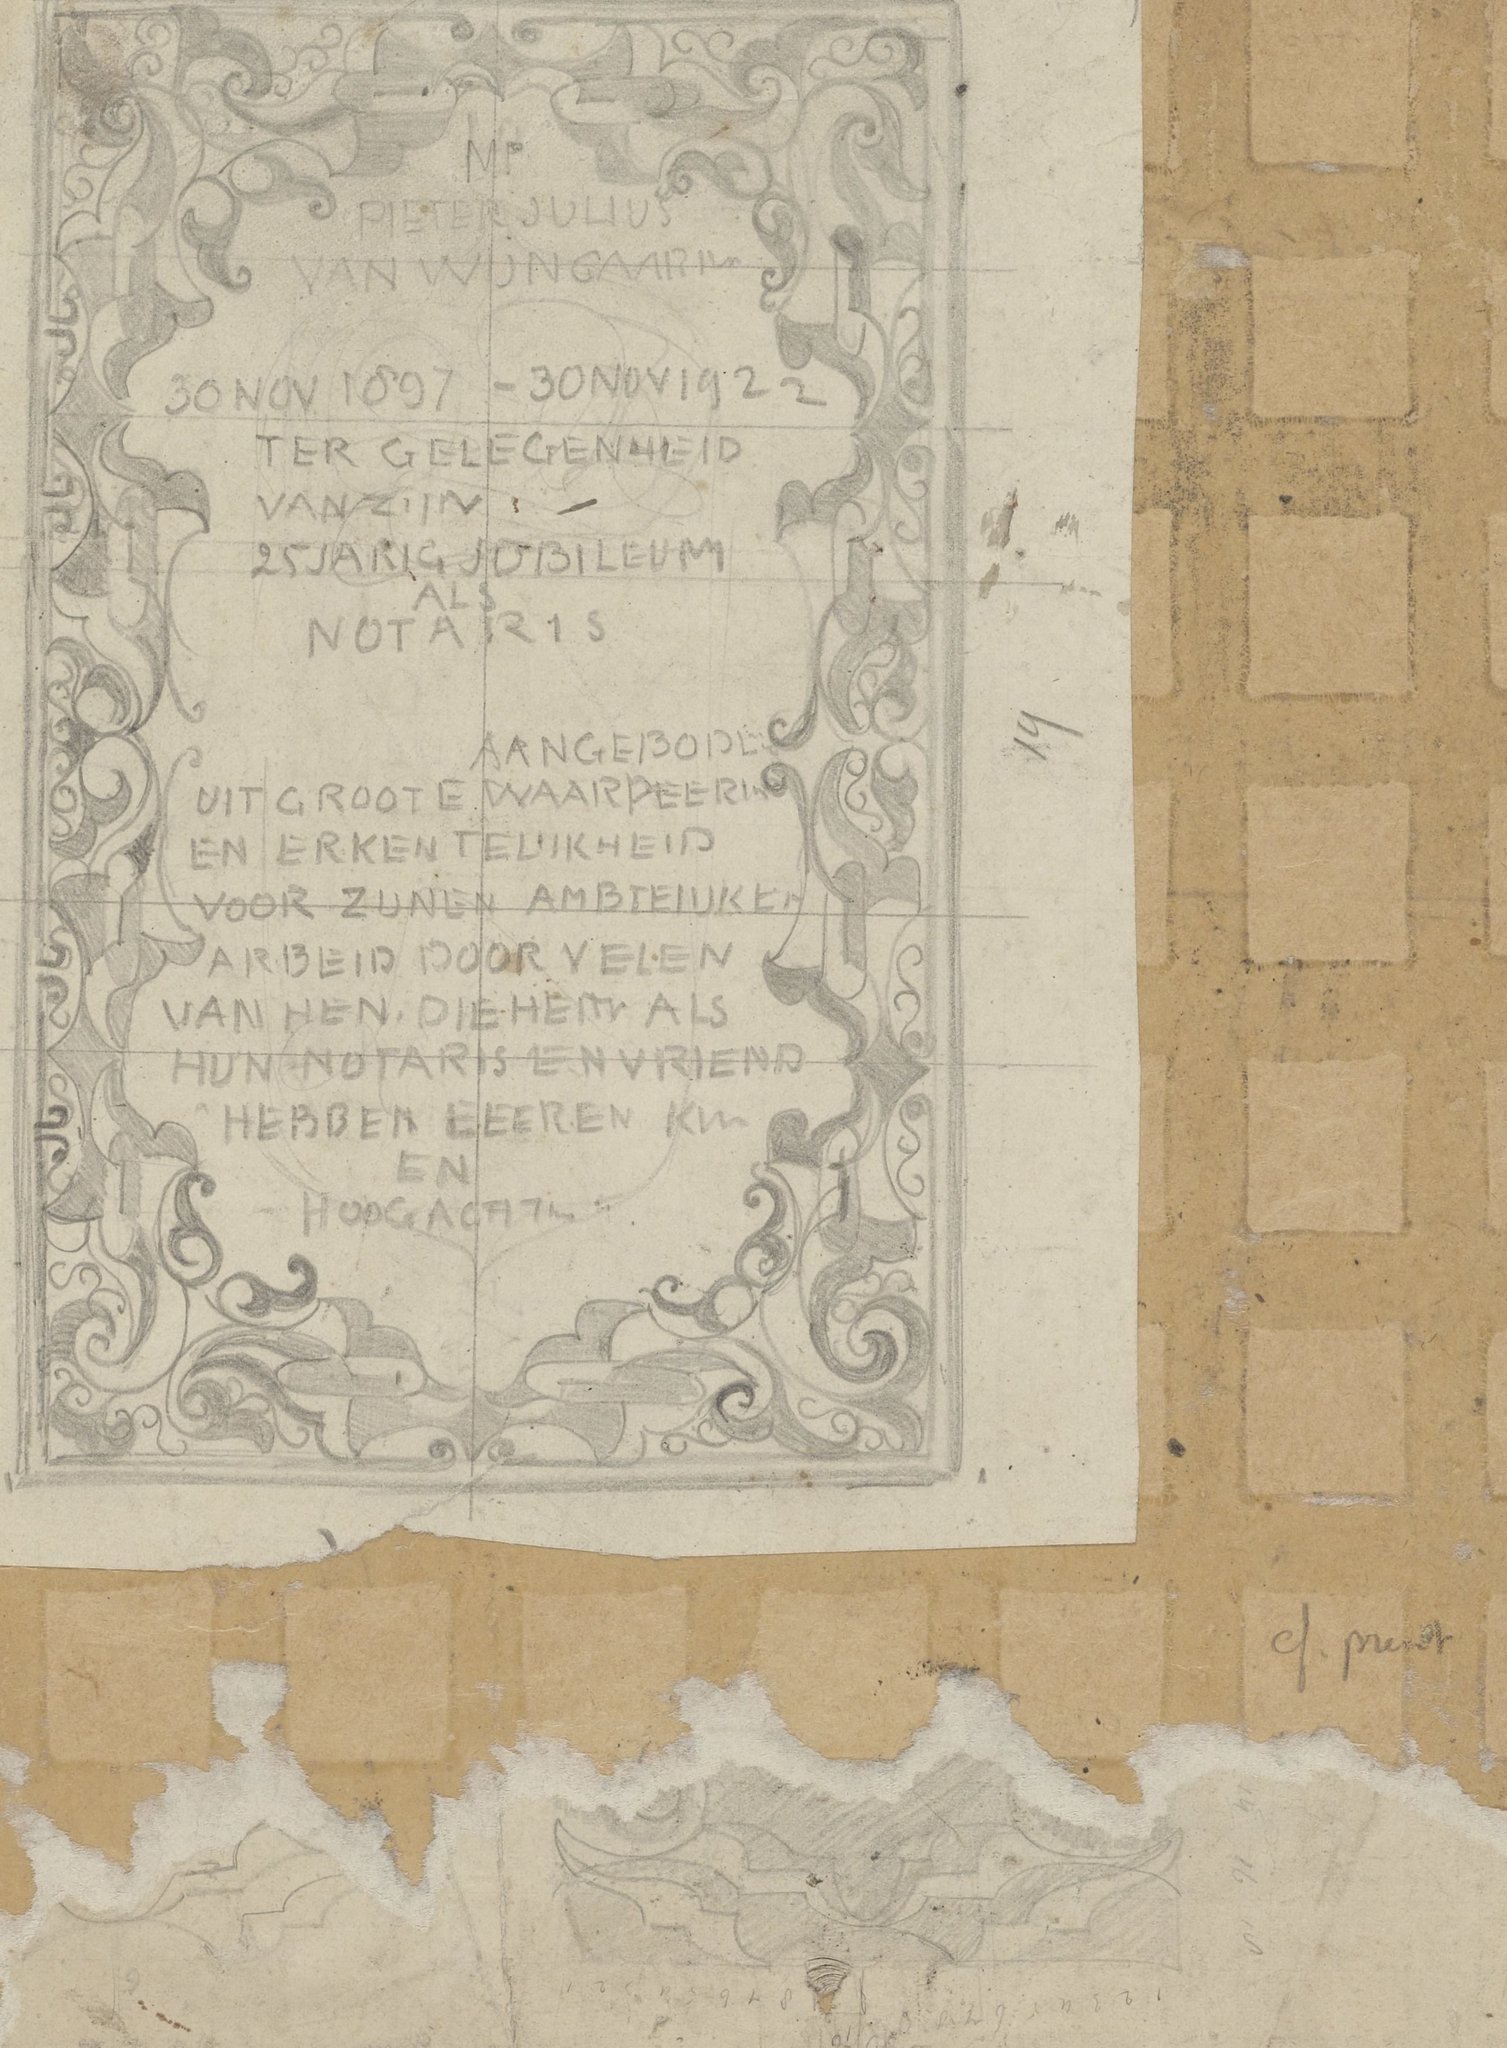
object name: drawing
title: Ontwerp voor oorkonde voor Pieter Julius van Wijngaarden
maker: carel adolph lion cachet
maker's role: draughtsman, print maker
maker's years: 1864-1945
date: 1874-1945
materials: paper, pencil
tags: p.j. van wijngaarden, decoration of printed matter